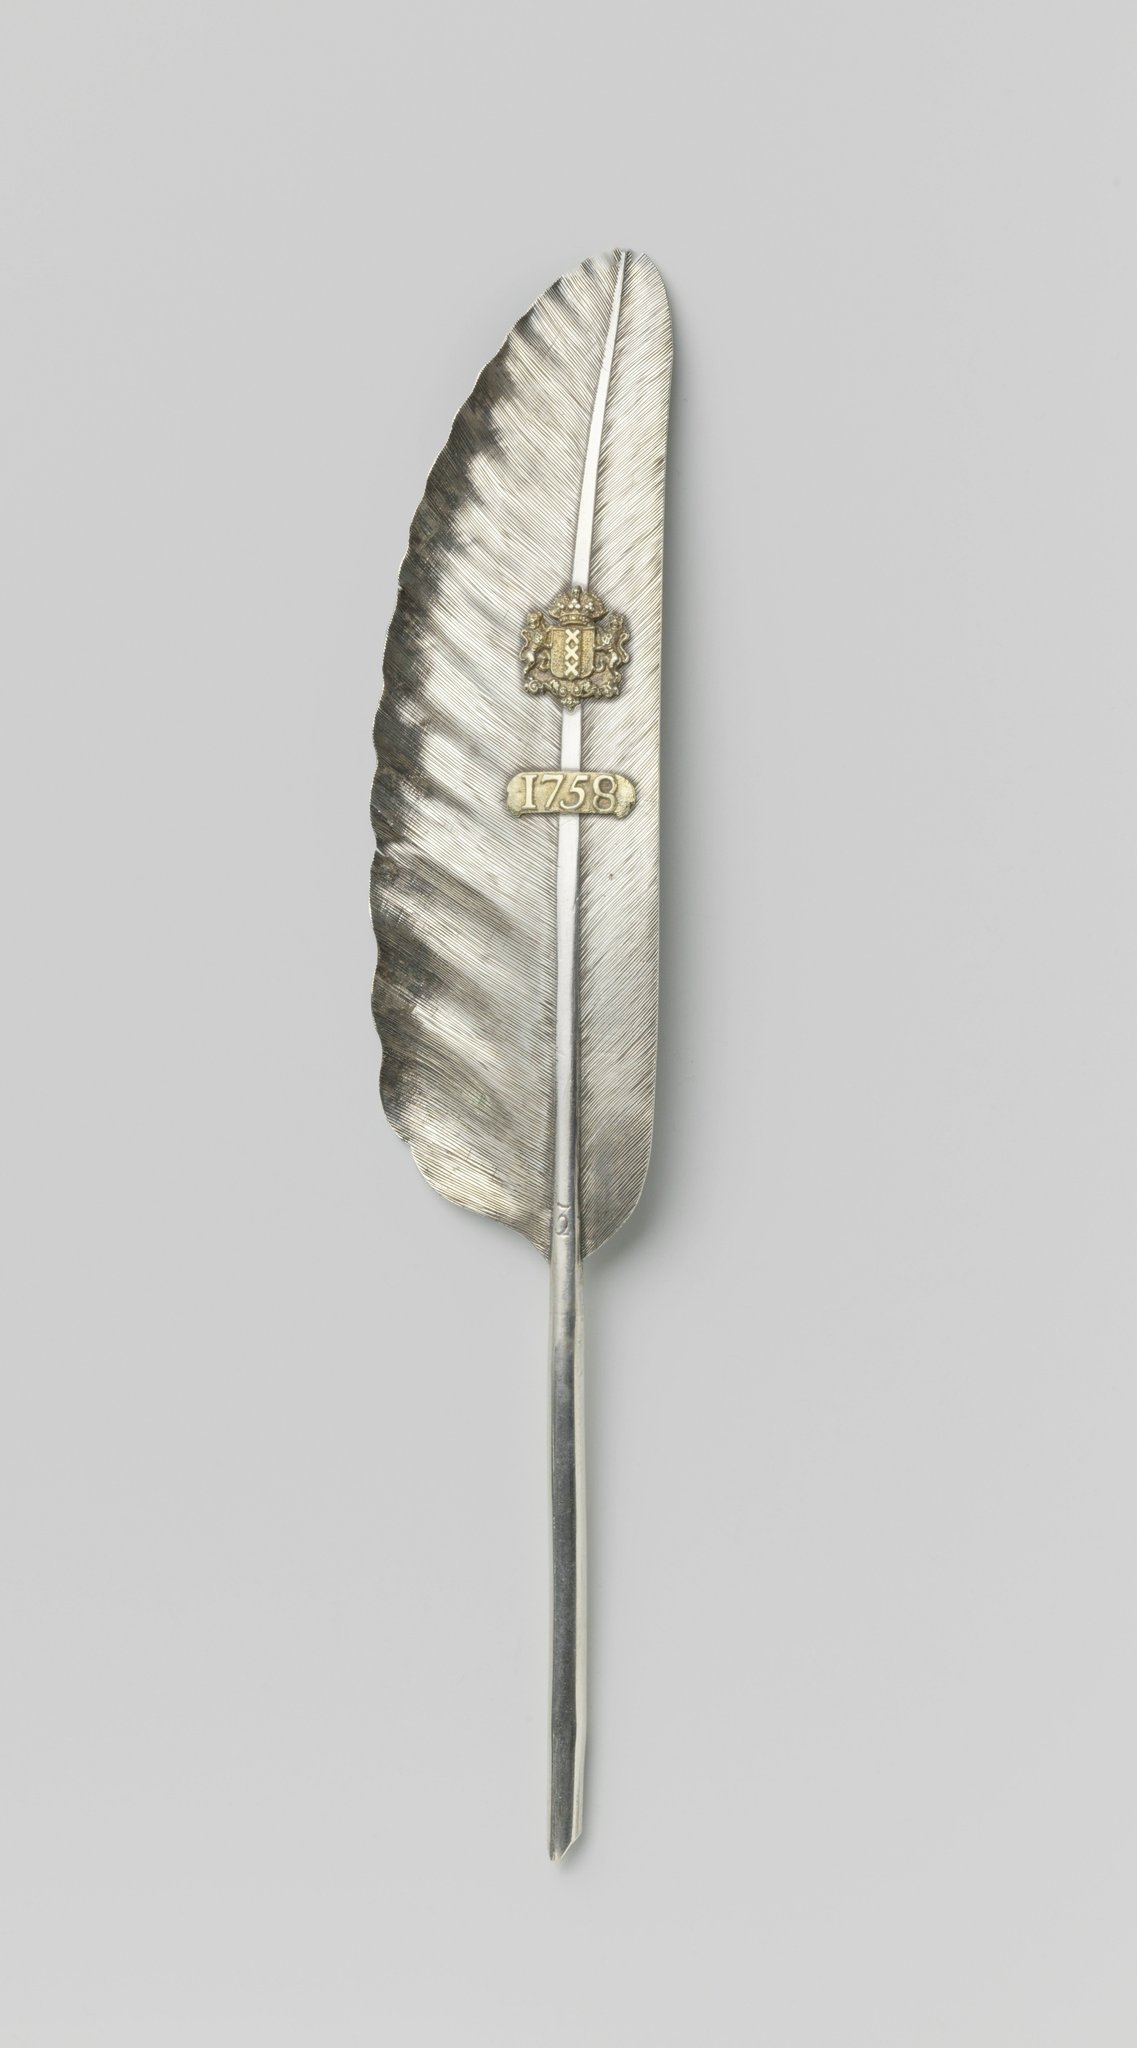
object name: prijspen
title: Prijspen met het wapen van Amsterdam en het jaartal 1755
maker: hendrik hop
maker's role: silversmith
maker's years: 1732-1816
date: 1755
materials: silver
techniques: casting, gilding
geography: amsterdam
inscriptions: maker's mark, date letter: ‘V’, town mark, number: ‘3’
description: De pen heeft de vorm van een ganzenveer, waarop het gegoten, vergulde, gekroonde wapen van Amsterdam, gehouden door leeuwen die staan op twee bladvoluten ter weerszijden van een culot, is geappliqueerd. Daaronder is een gegoten, verguld plaatje met jaartal 1758 geappliqueerd. In de schacht is het cijfer 3 gegrift.